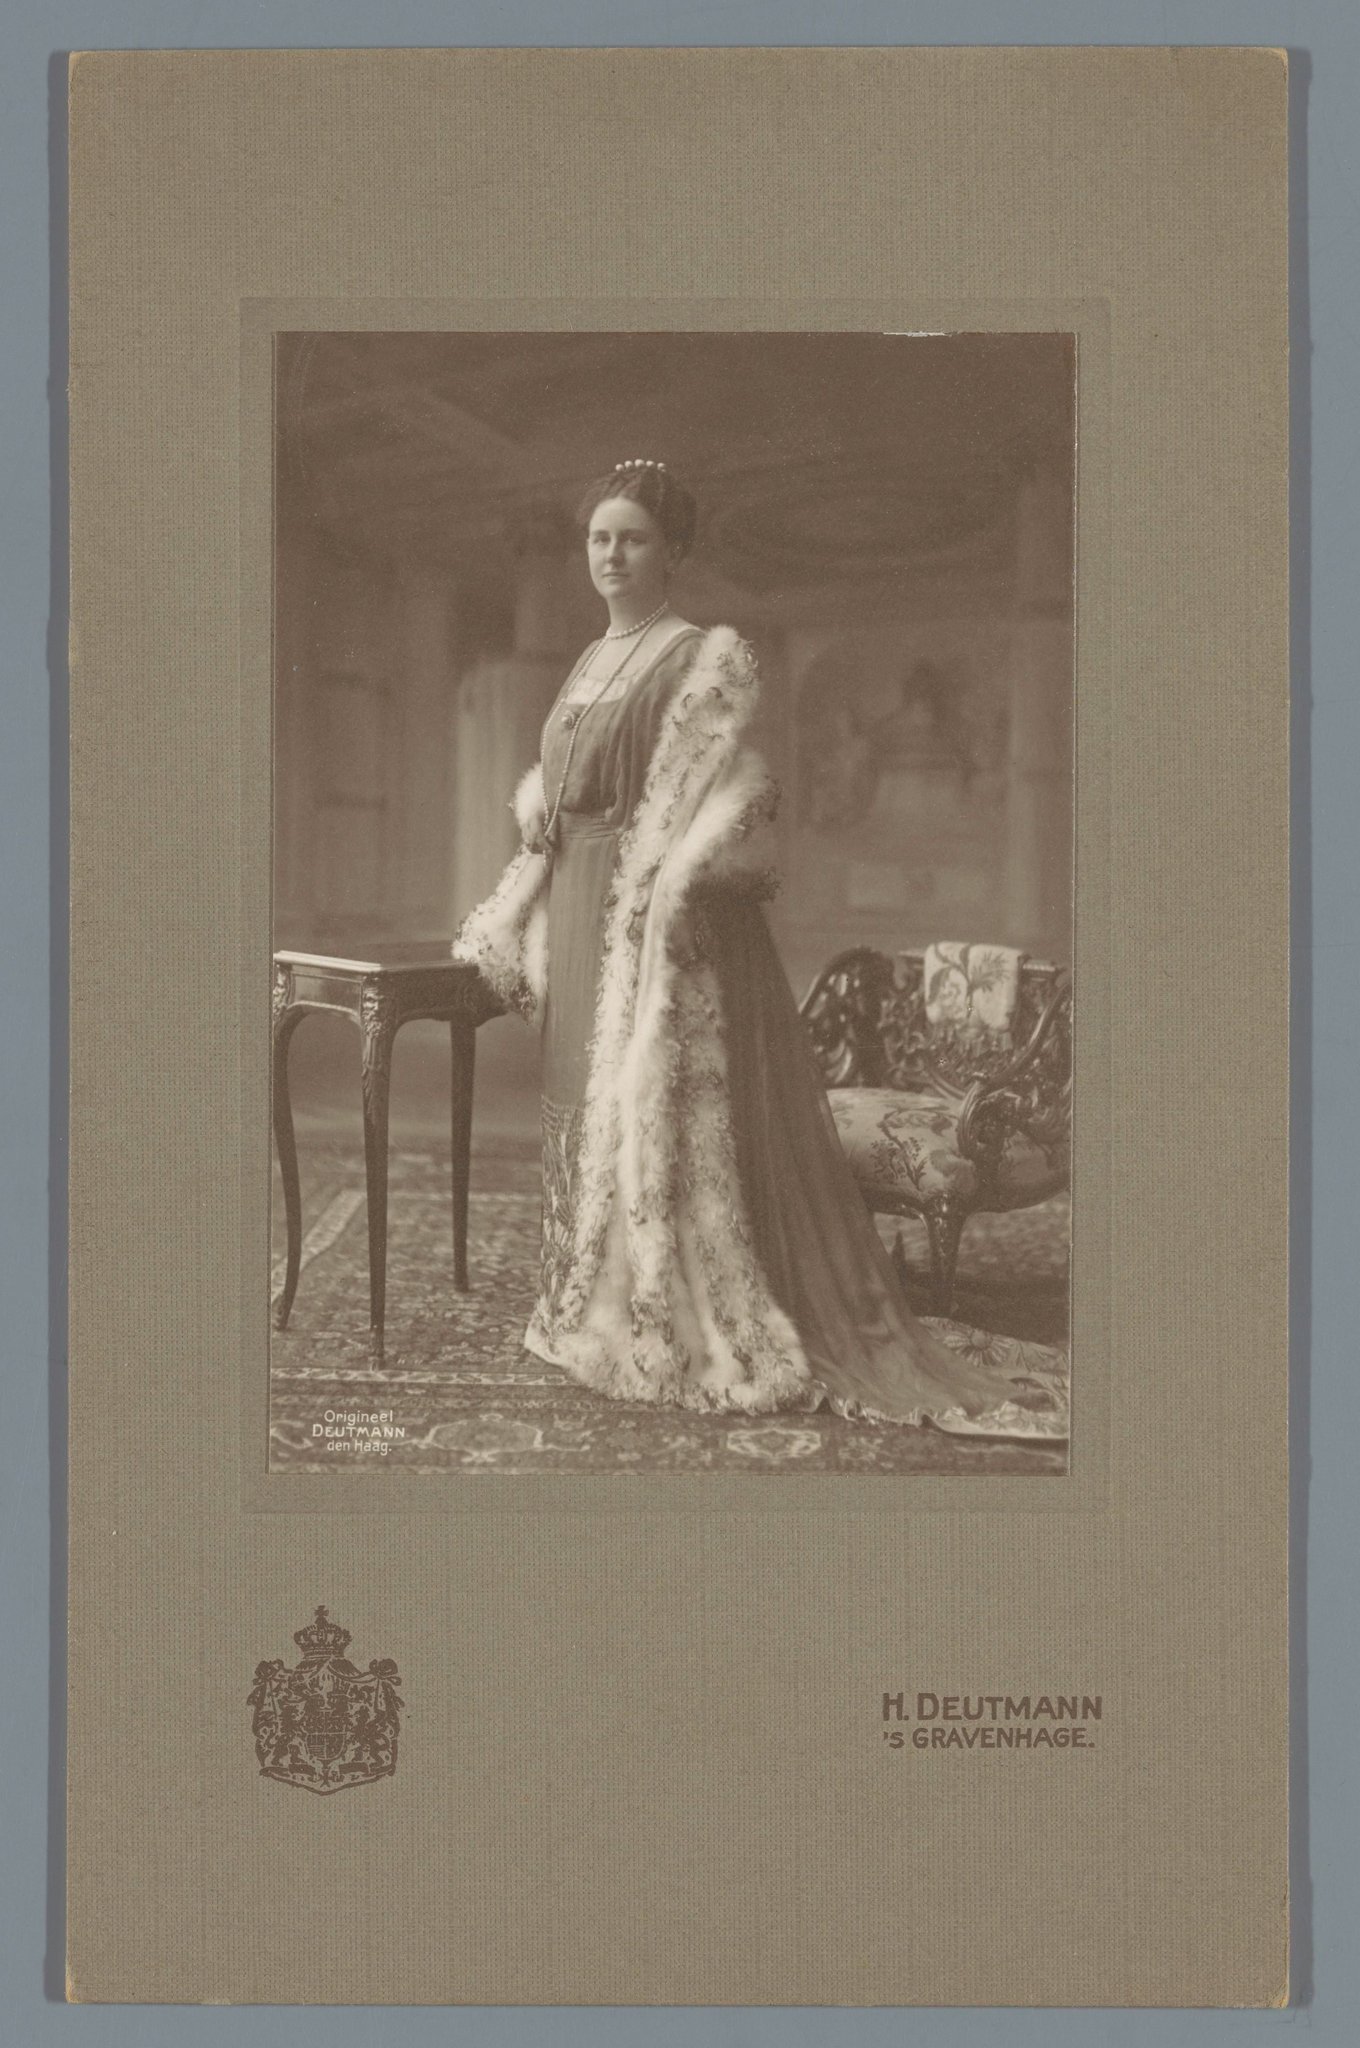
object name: cabinet photograph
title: Portret van koningin Wilhelmina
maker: herman deutmann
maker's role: fotograaf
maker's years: 1870-1926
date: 1904-1912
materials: cardboard, photographic support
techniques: matte daylight collodion silver print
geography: the hague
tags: print maker, wilhelmina of the netherlands, historical persons, queen, pearl; pearl necklace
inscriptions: name: ‘H. DEUTMANN/ 'S GRAVENHAGE.’, number: ‘40’, inscription: ‘Wilhelmina/ 31-8-1912’